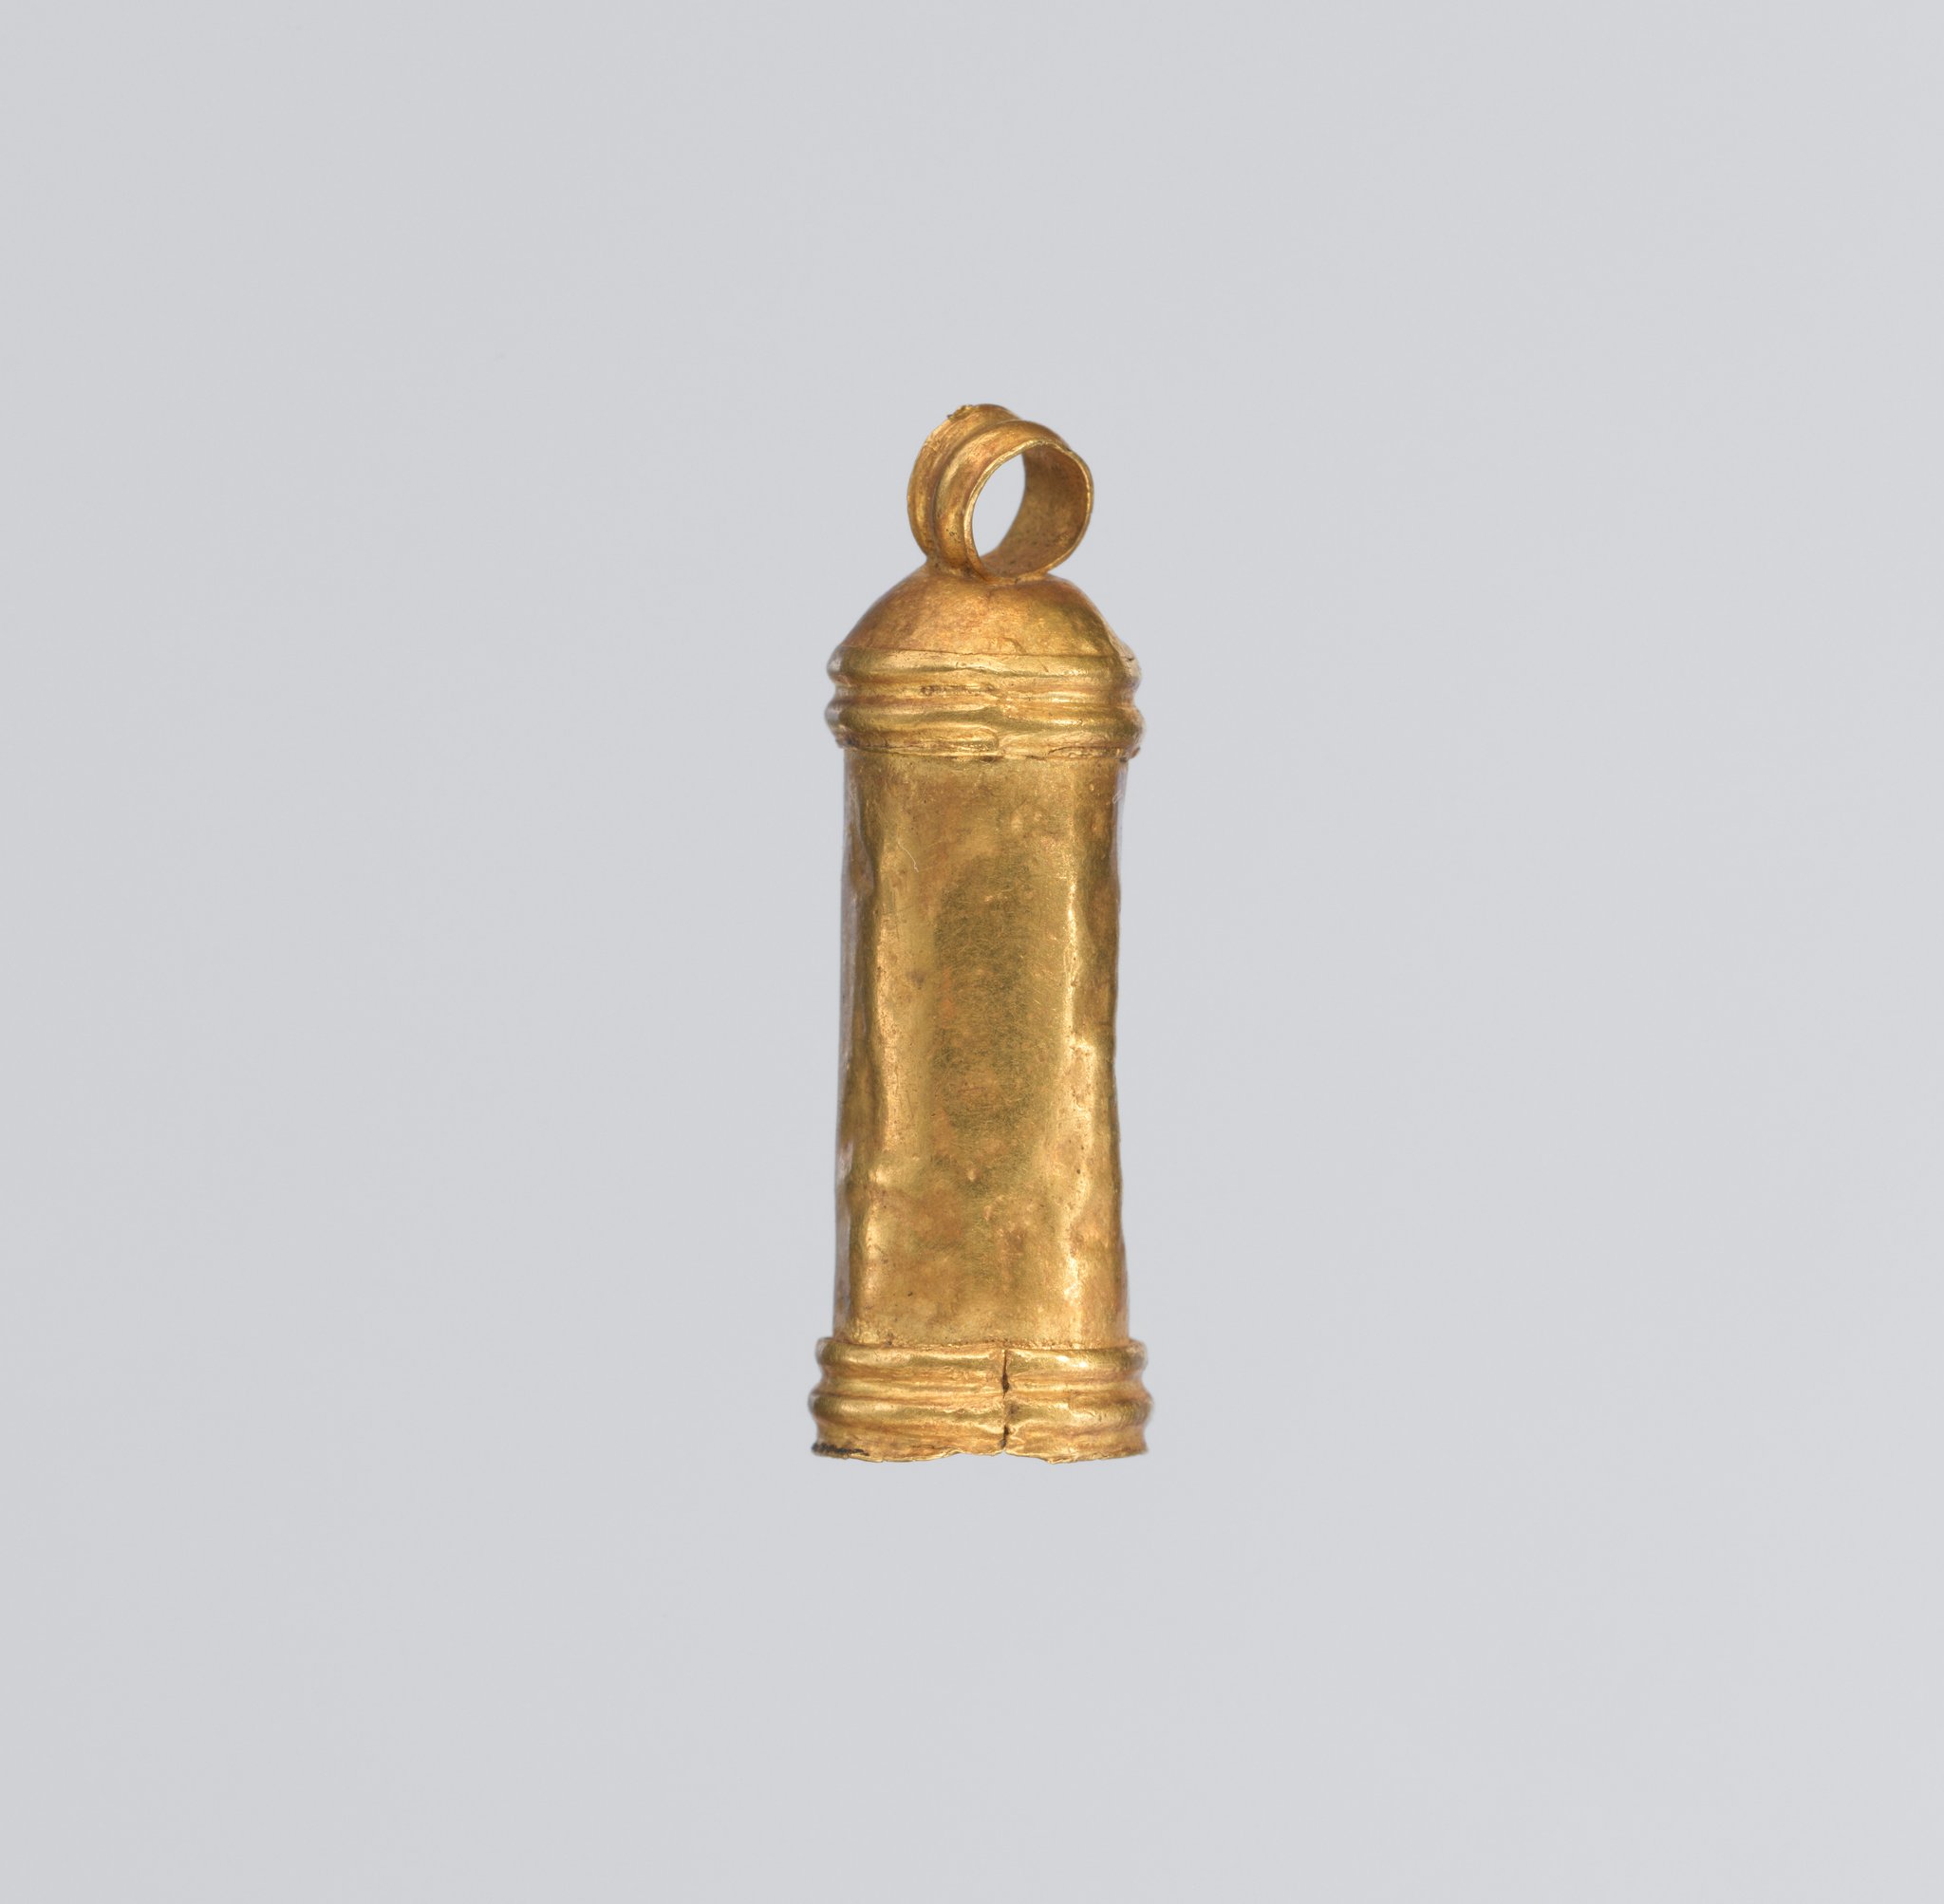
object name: amulet case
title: Gold amulet case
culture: cypro-phoenician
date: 700-101 BCE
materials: gold